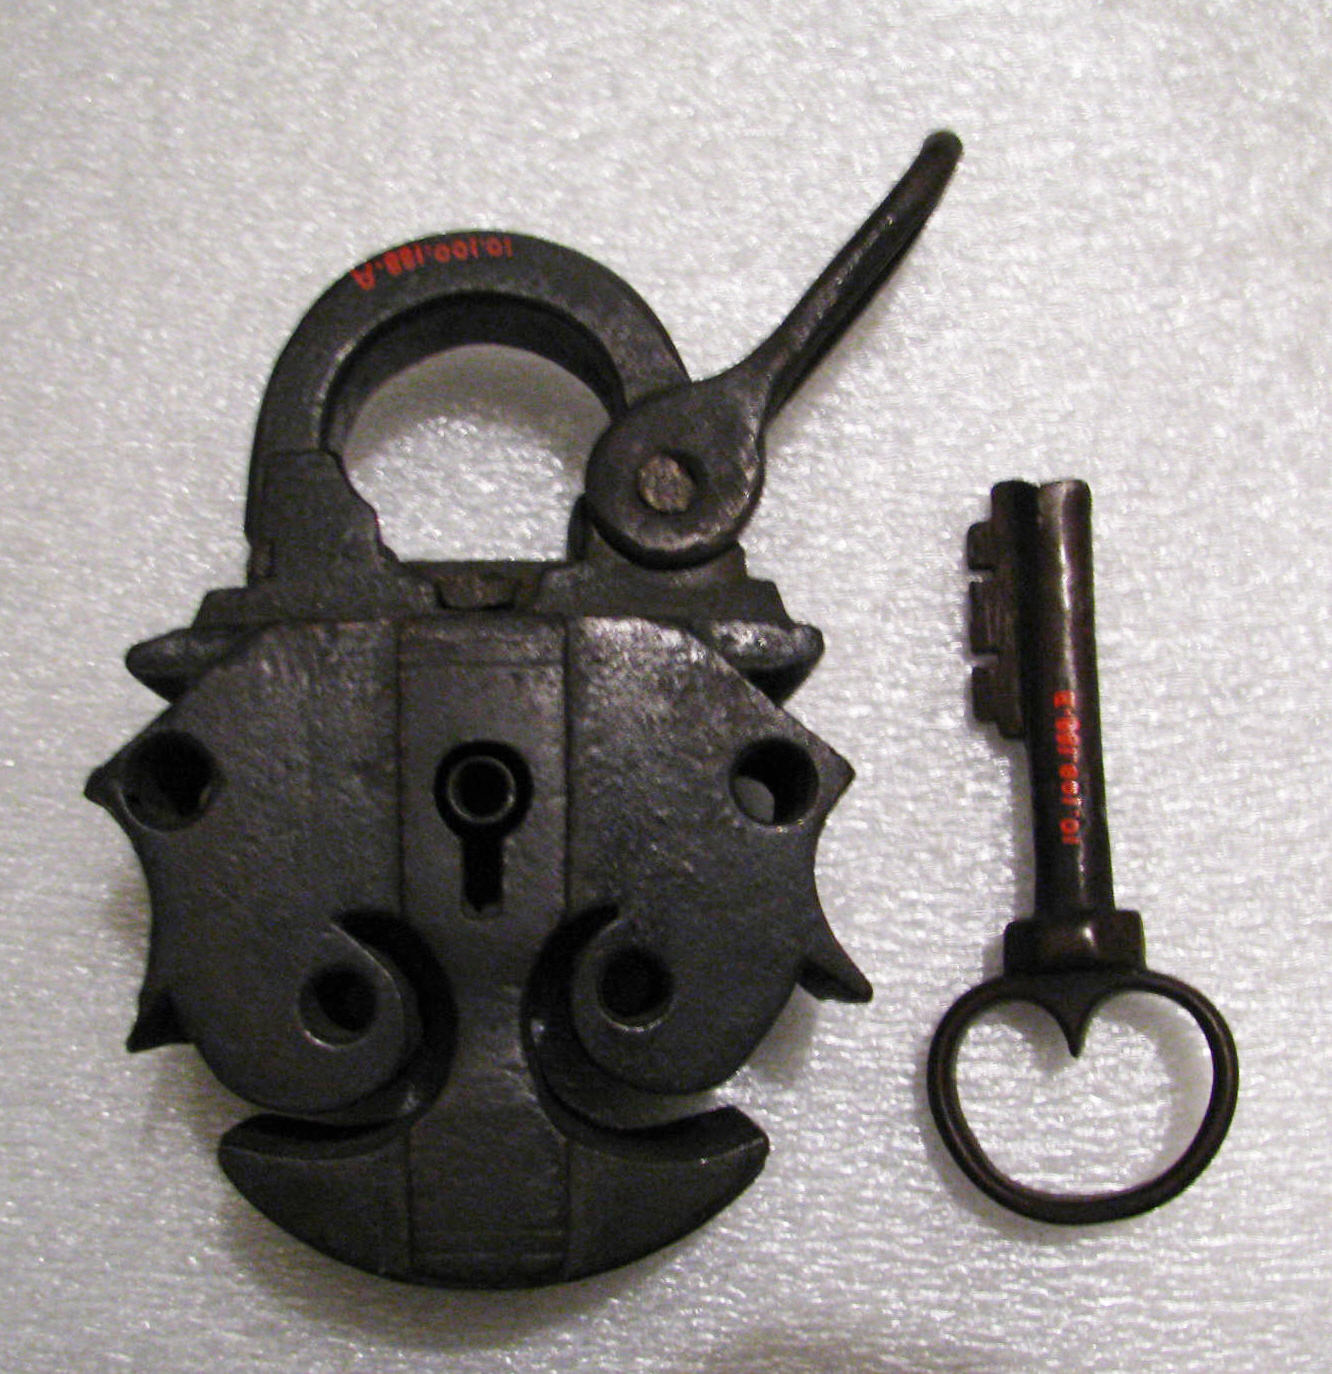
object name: padlock with key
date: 1501-1600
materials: iron